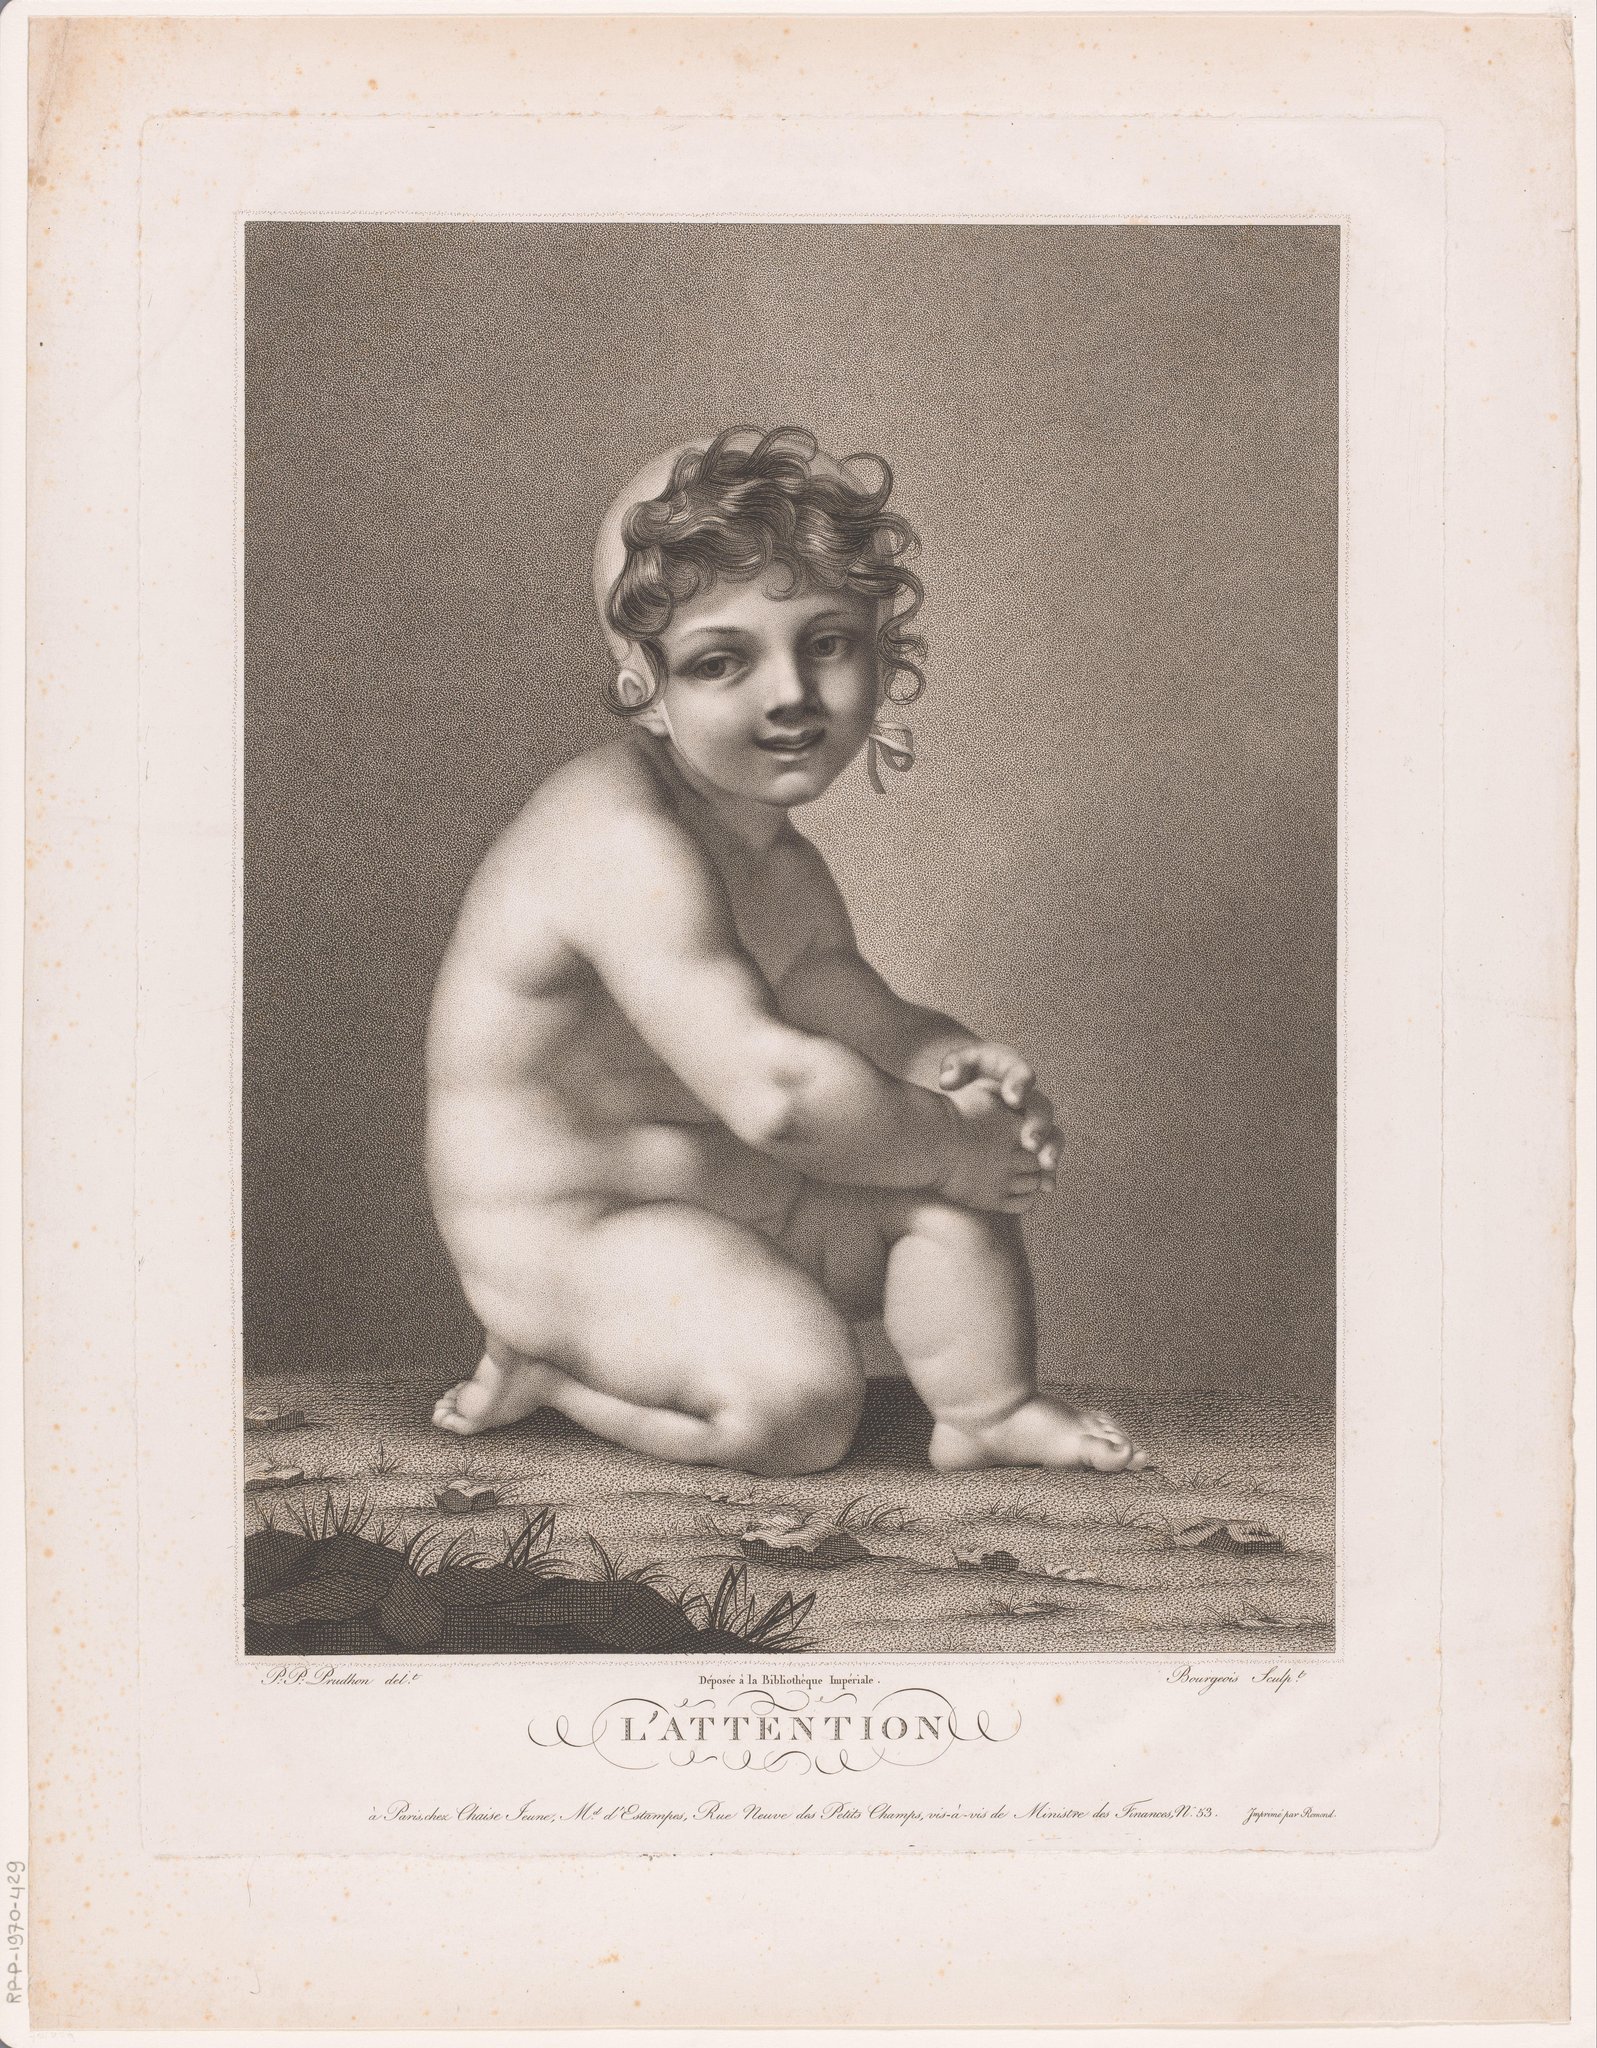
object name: print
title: L'Attention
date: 1770-1825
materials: paper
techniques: etching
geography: paris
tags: attention, concentration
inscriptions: collector's mark: Lugt 2228, : ‘Déposé à la Bibliothèque Impériale’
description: Knielend naakt kind als personificatie van aandacht en concentratie.